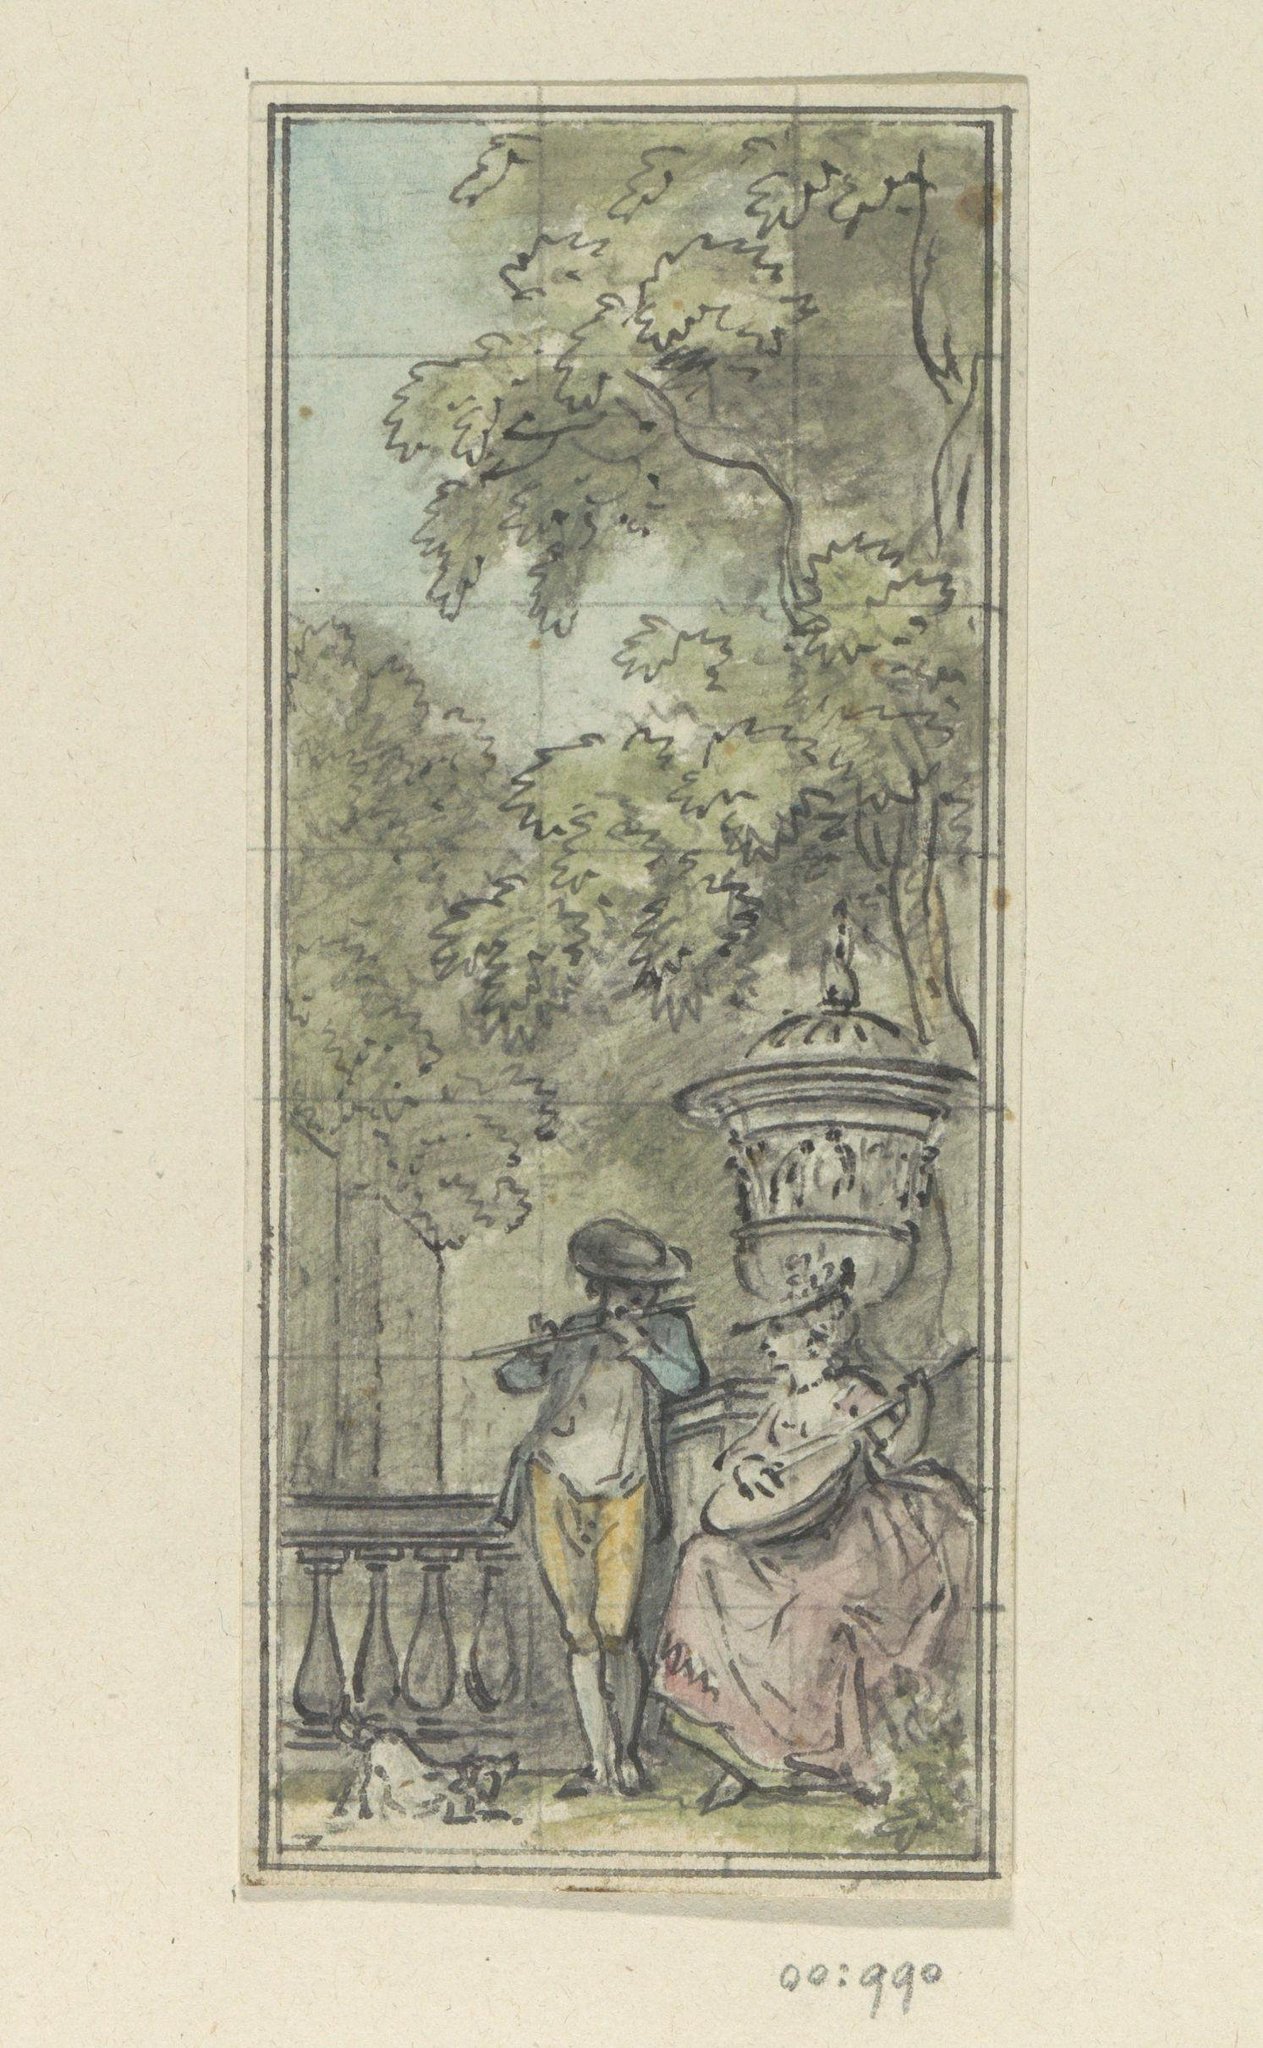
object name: album leaf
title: Musicerende man en vrouw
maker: jurriaan andriessen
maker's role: draughtsman, painter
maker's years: 1742-1819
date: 1760-1819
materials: paint, paper, pencil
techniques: brush, pen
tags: making music; musician with instrument, garden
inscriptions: inscription: ‘hoog 6.10/breed 2.8 1/2 [...]/ Charponet[?] by den Hr/ van A[...]’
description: Mogelijk een ontwerptekening voor een kamerdecoratie. Met op de achtergrond een raster. Tekening maakt deel uit van een album.